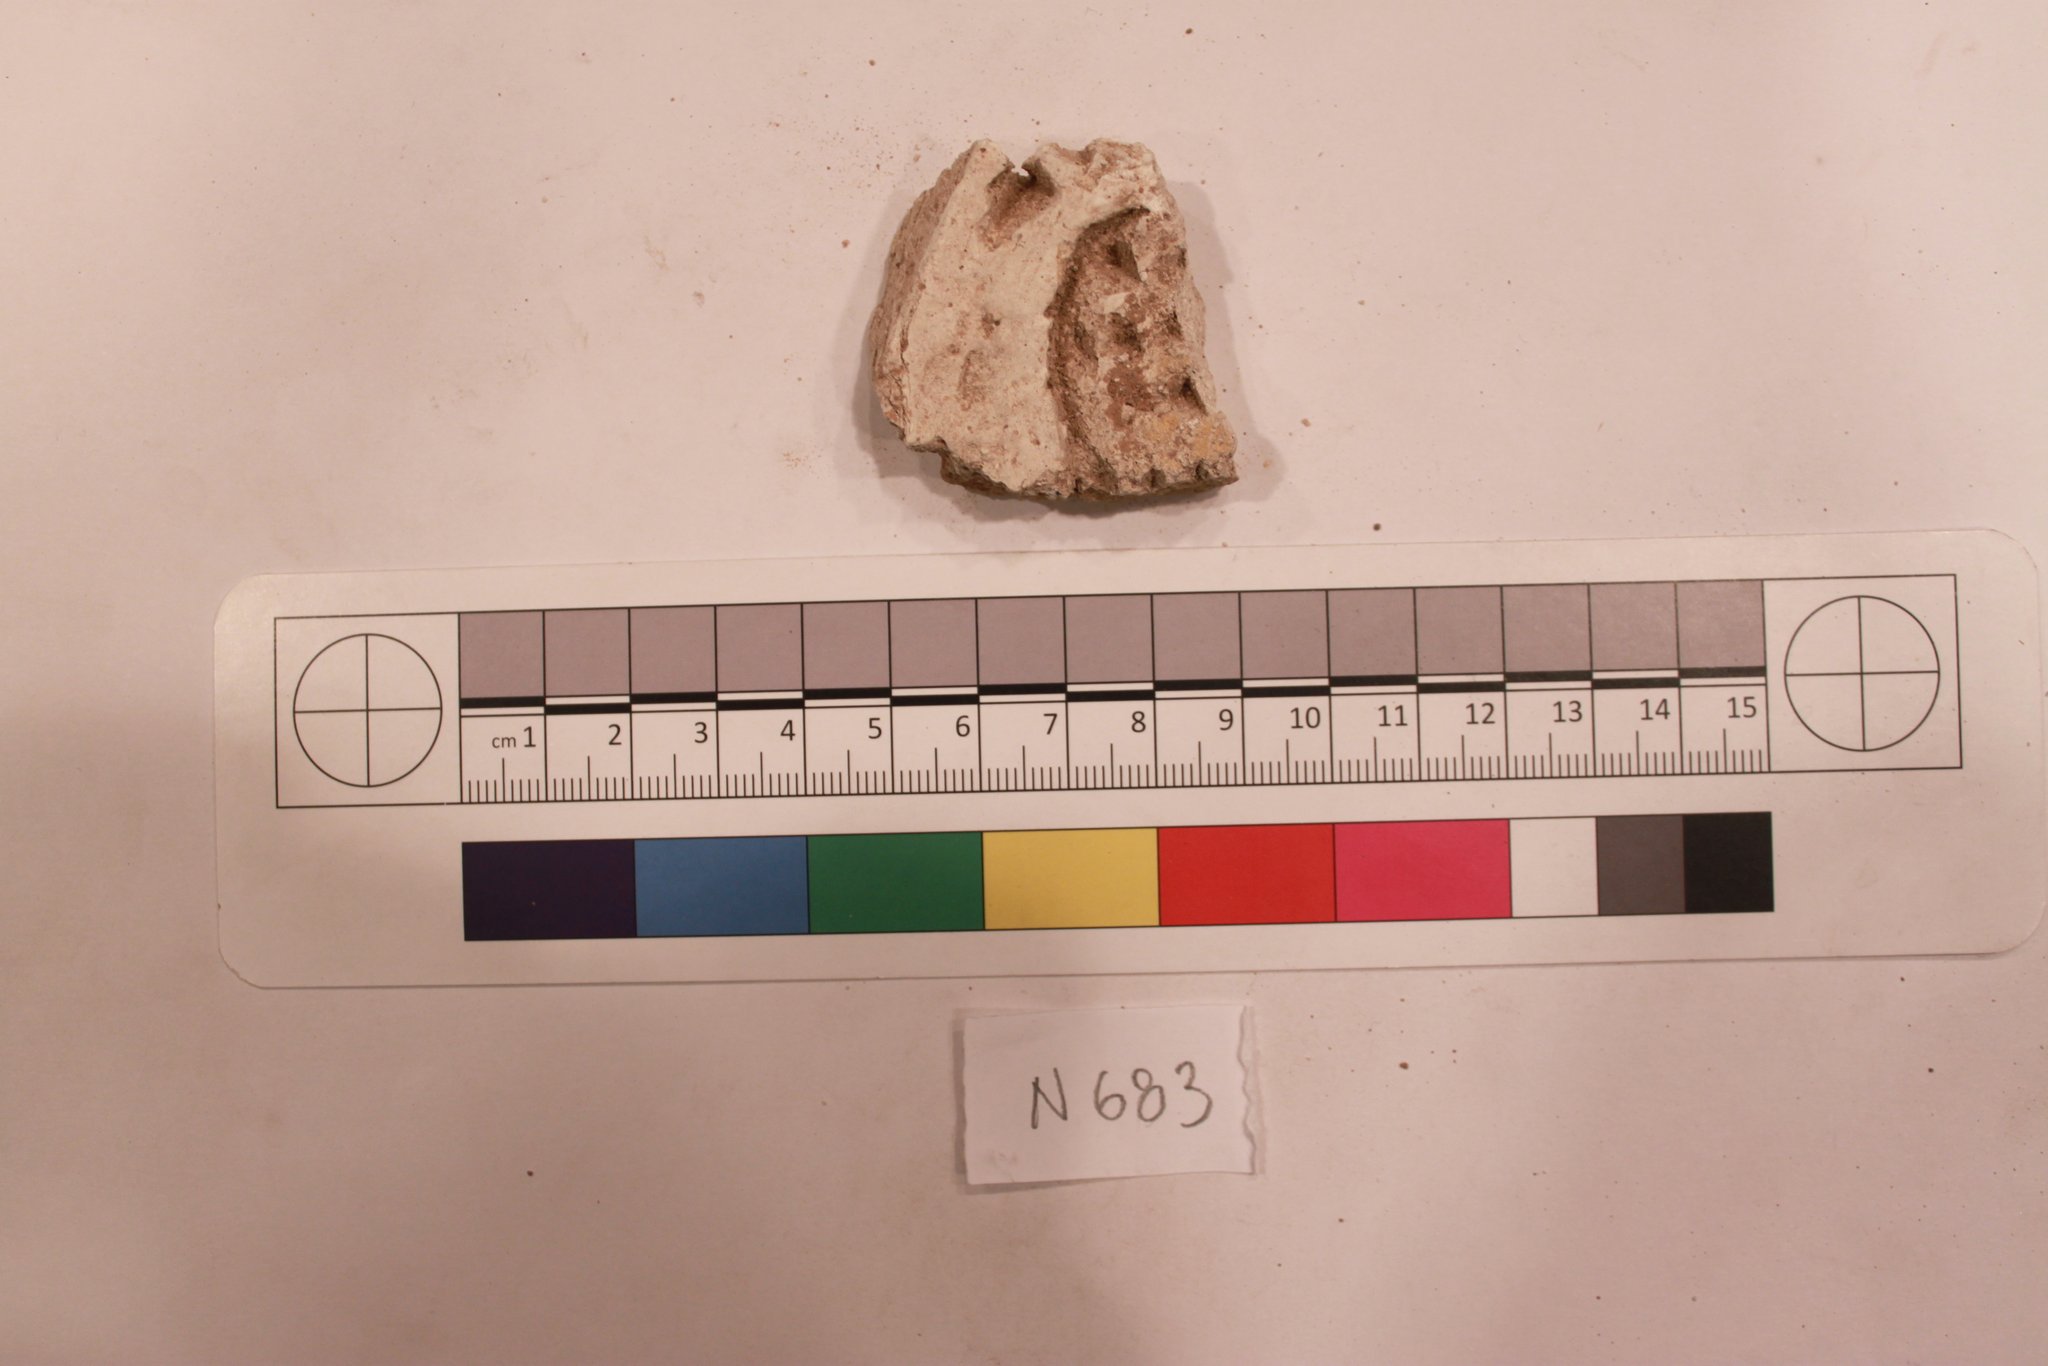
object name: fragment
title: Stucco Fragment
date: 701-1200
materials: plaster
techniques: carving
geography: iran